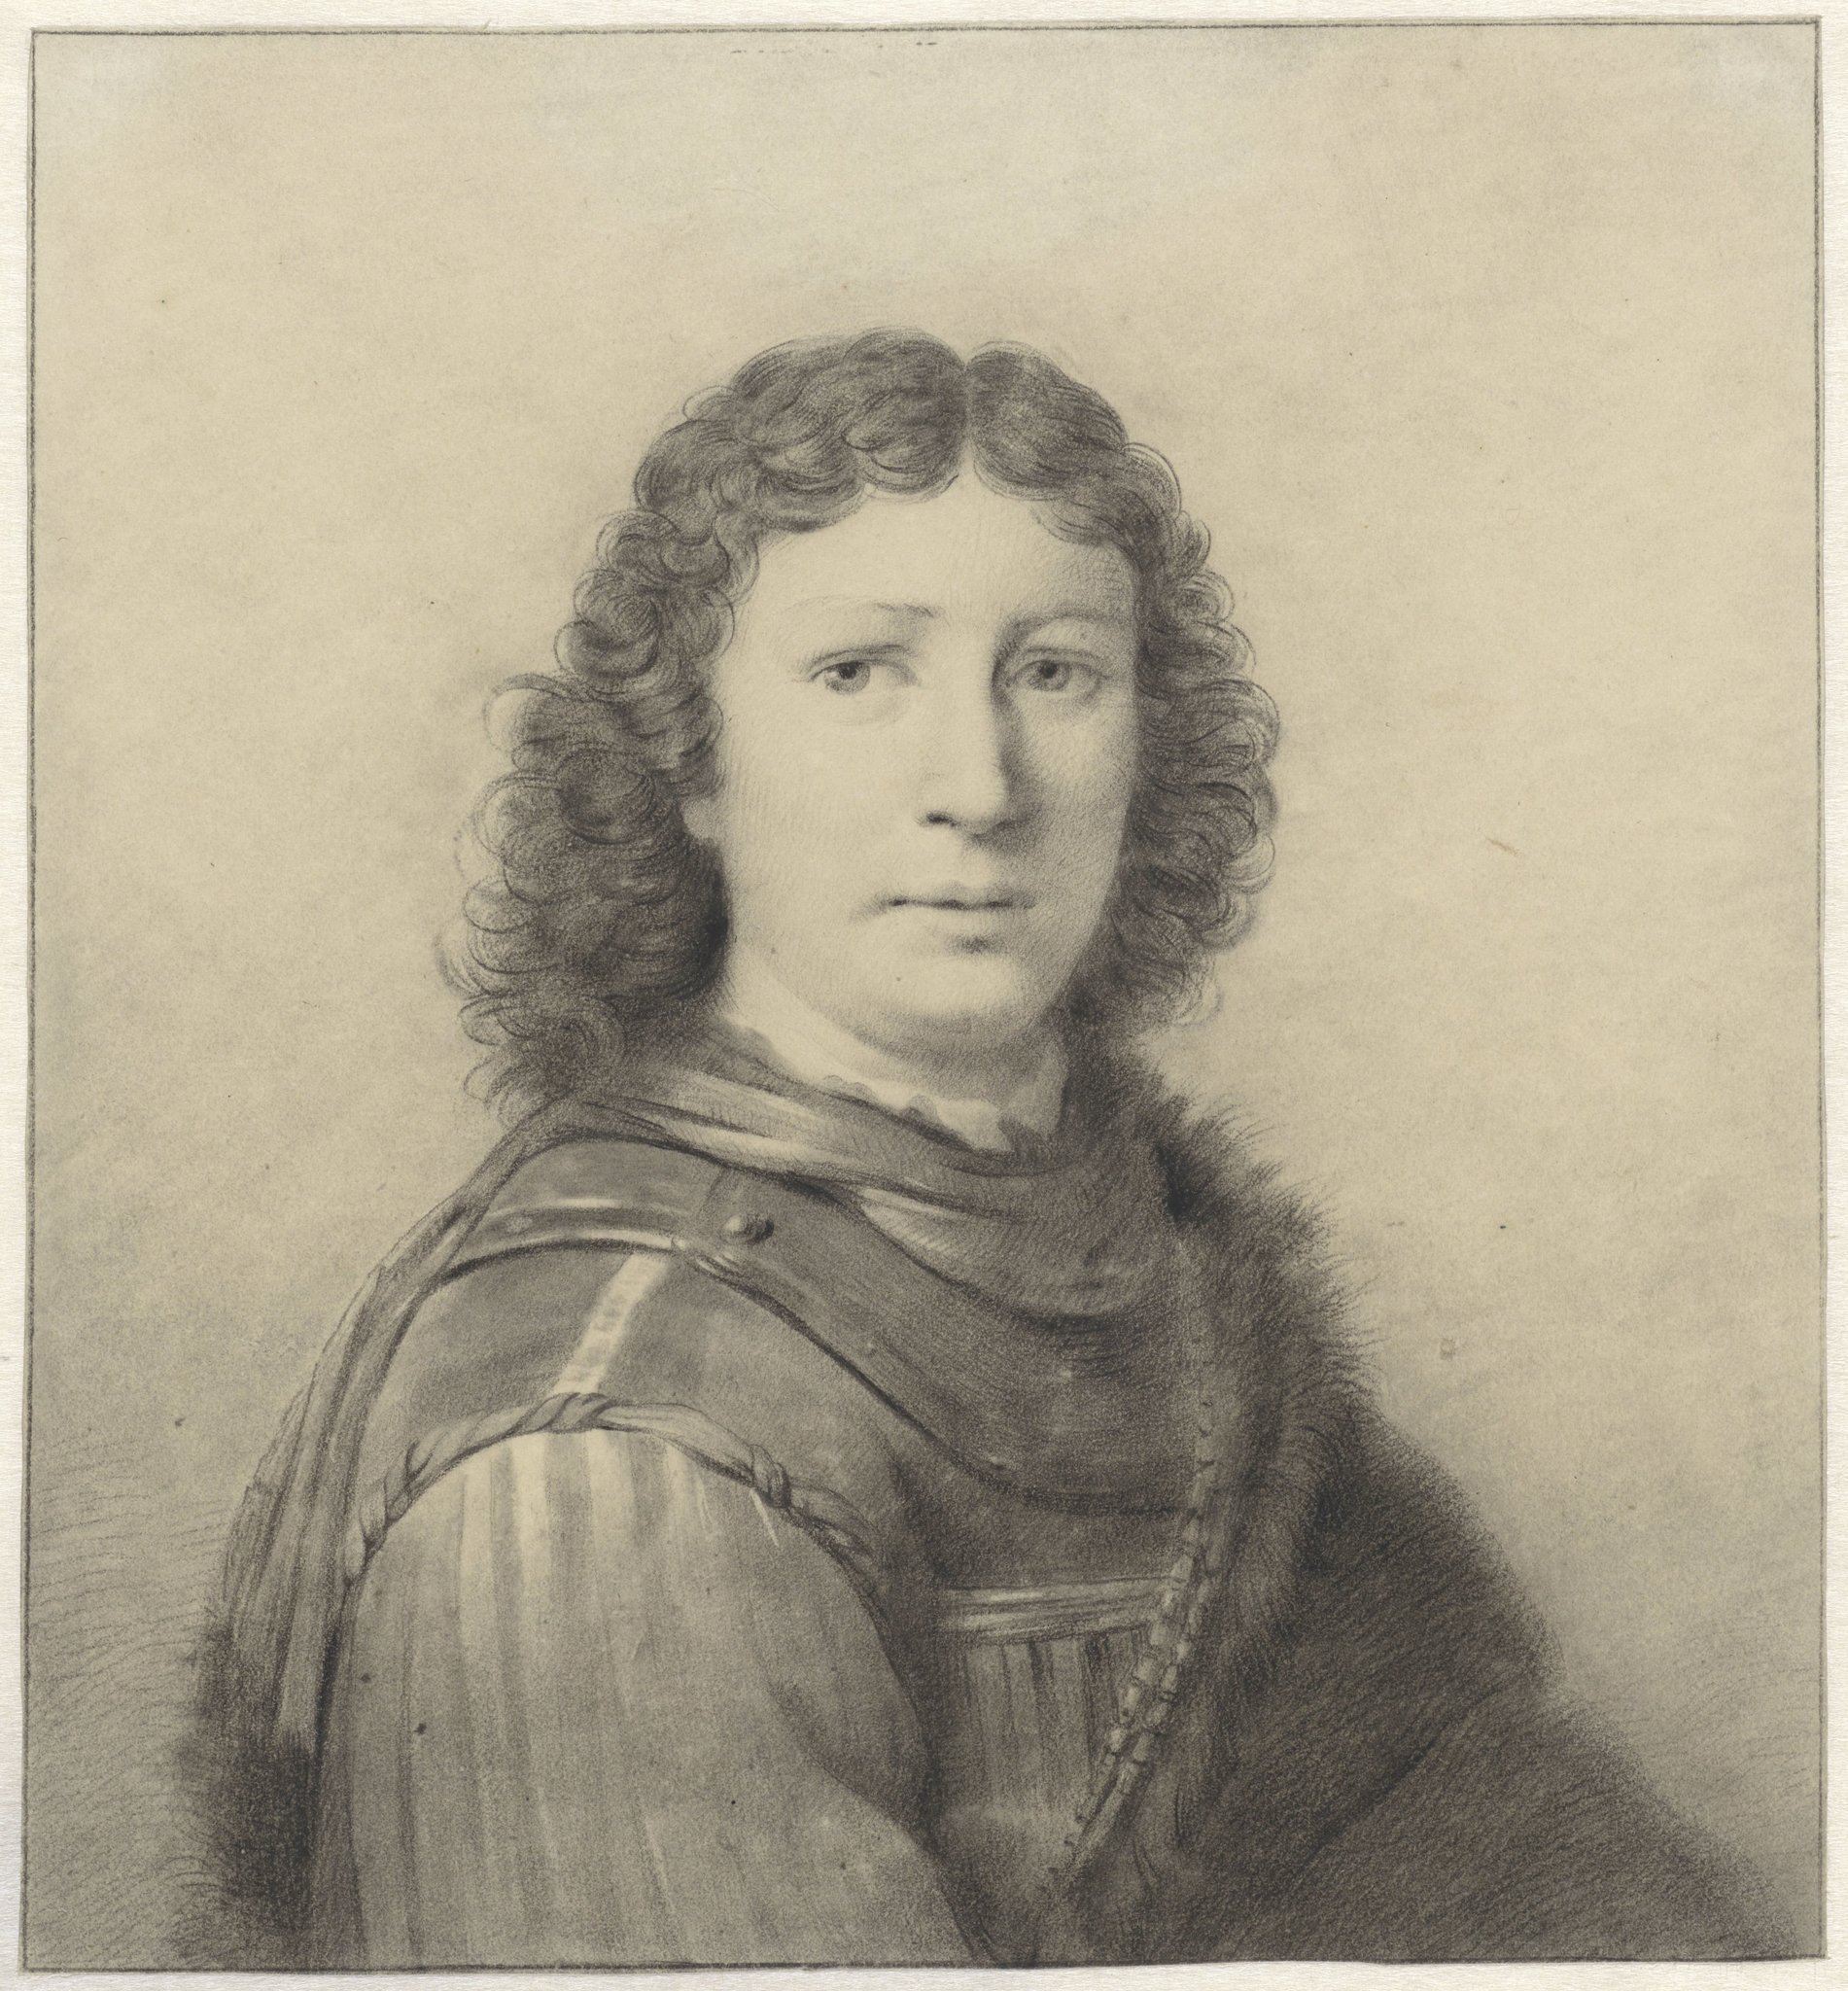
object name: drawing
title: Portret van een jongeman met halsberg en keten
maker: wilhelm adrian netscher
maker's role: draughtsman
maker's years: 1791-1851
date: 1821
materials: chalk, paper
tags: anonymous historical person portrayed alone